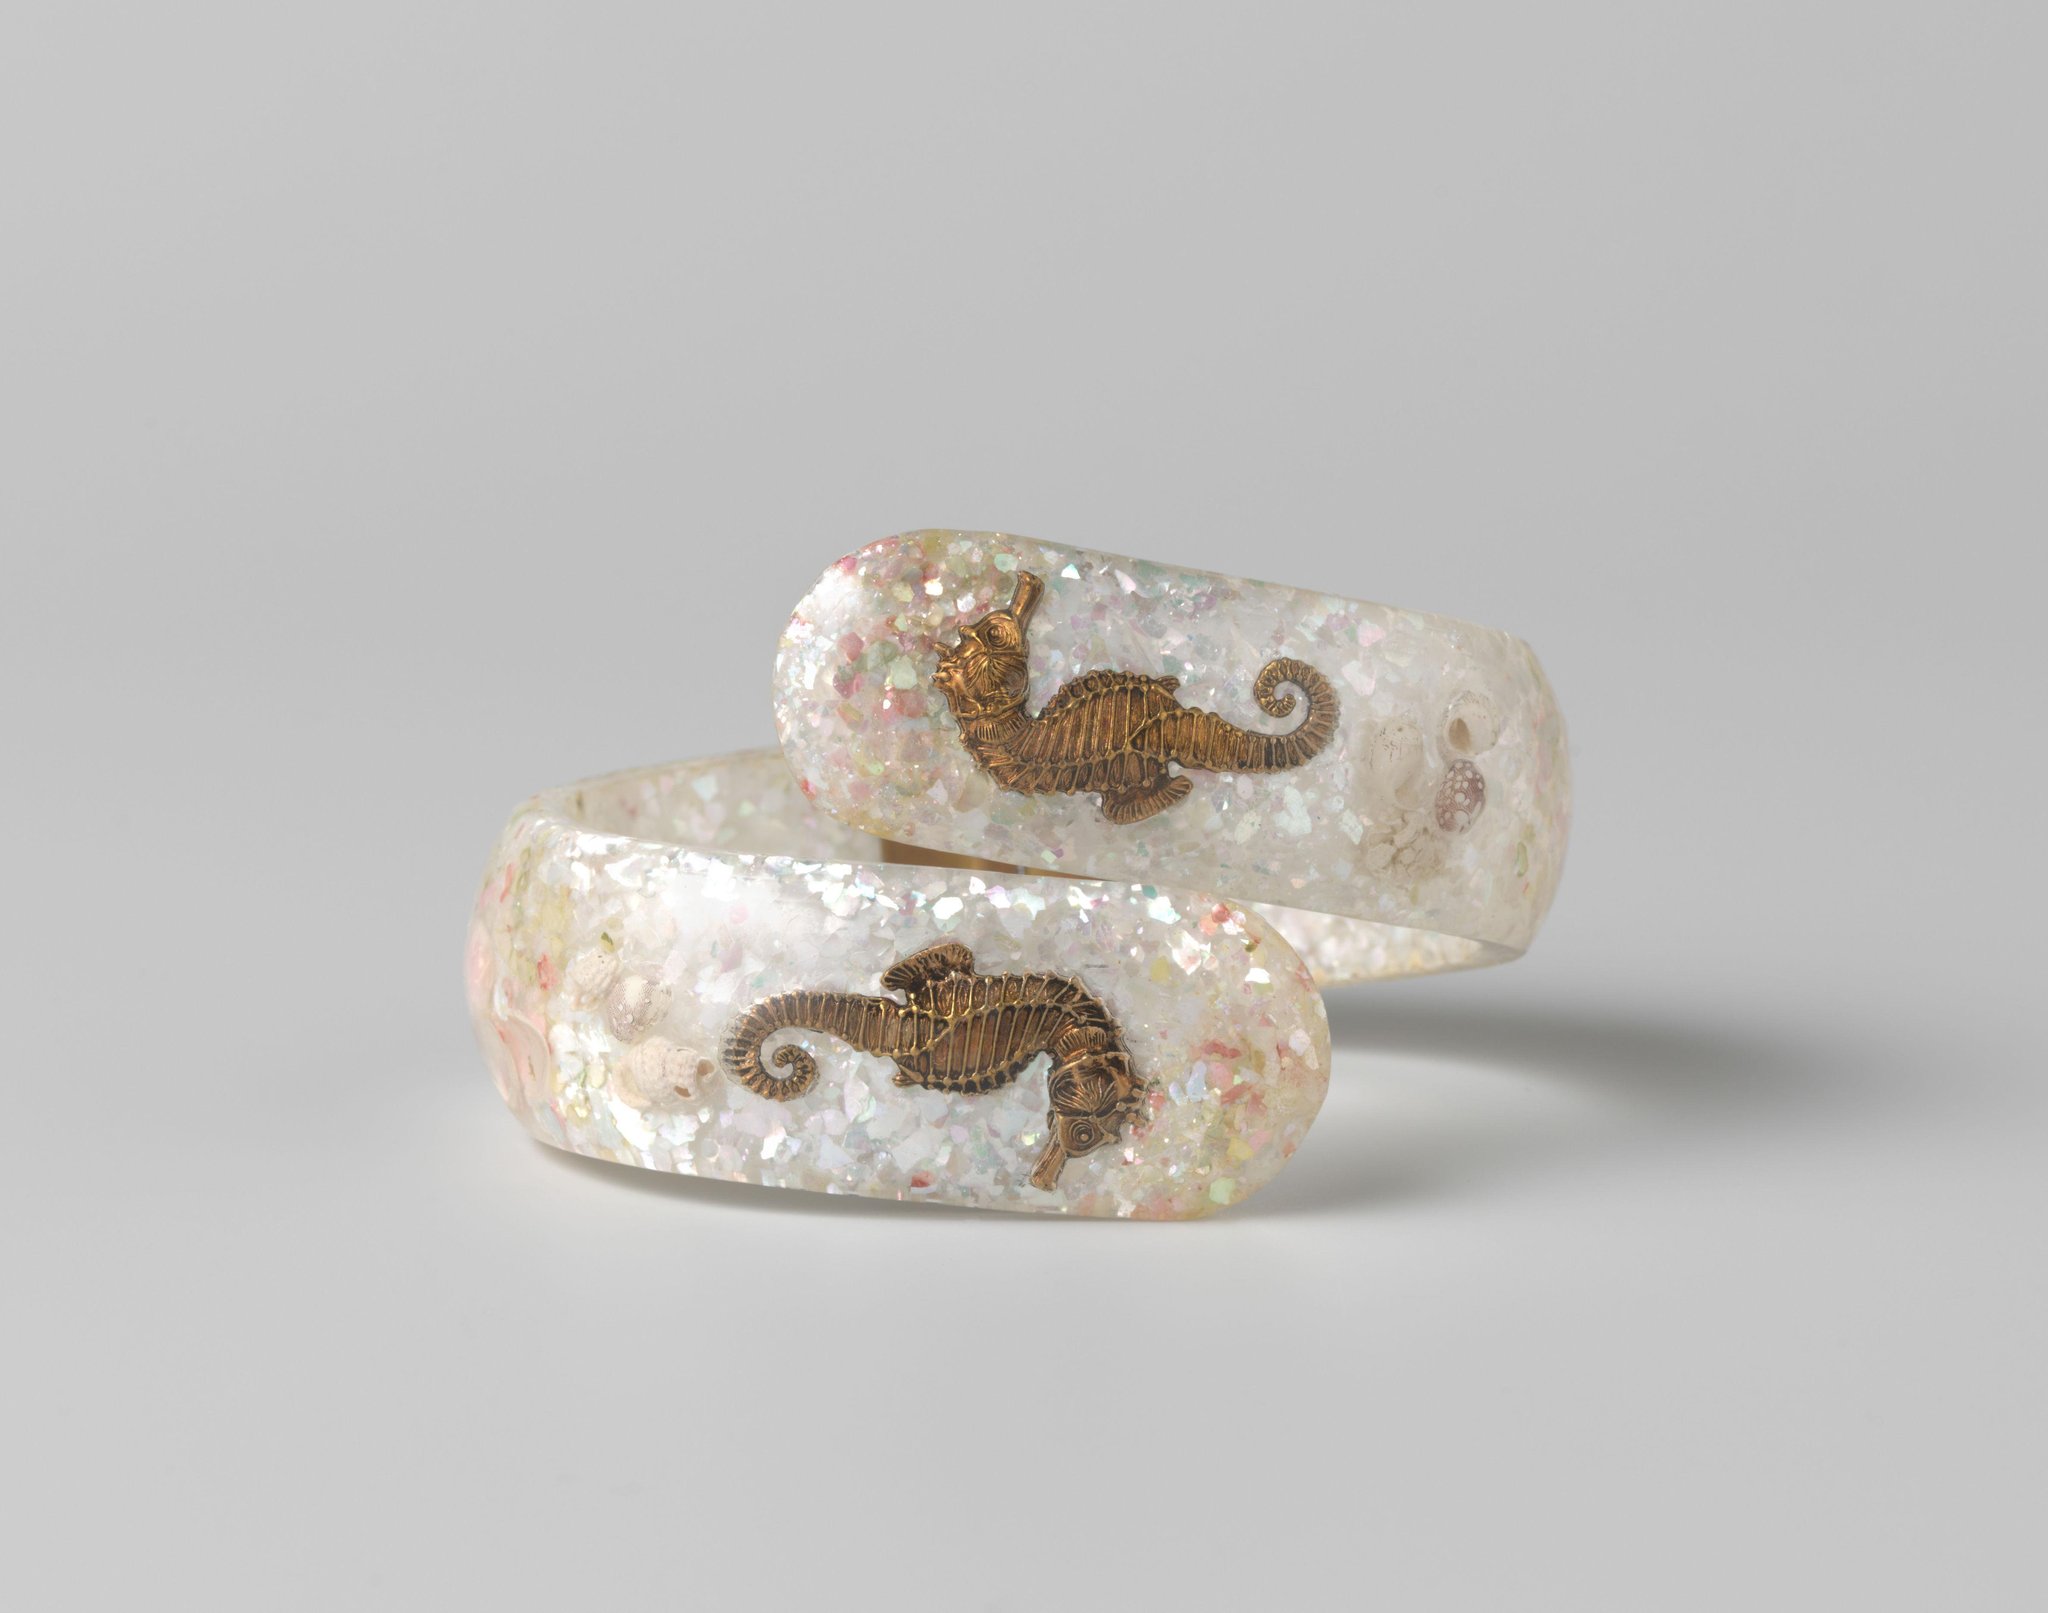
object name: bracelet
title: Klemarmband van transparant kunststof met twee zeepaarden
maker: Anonymous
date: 1940-1950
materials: metal, mother of pearl, plastic, shell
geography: united states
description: Klemarmband van transparant kunststof met daarin schilfers parelmoer en kleine schelpen en daarop twee zeepaarden van gelig metaal.